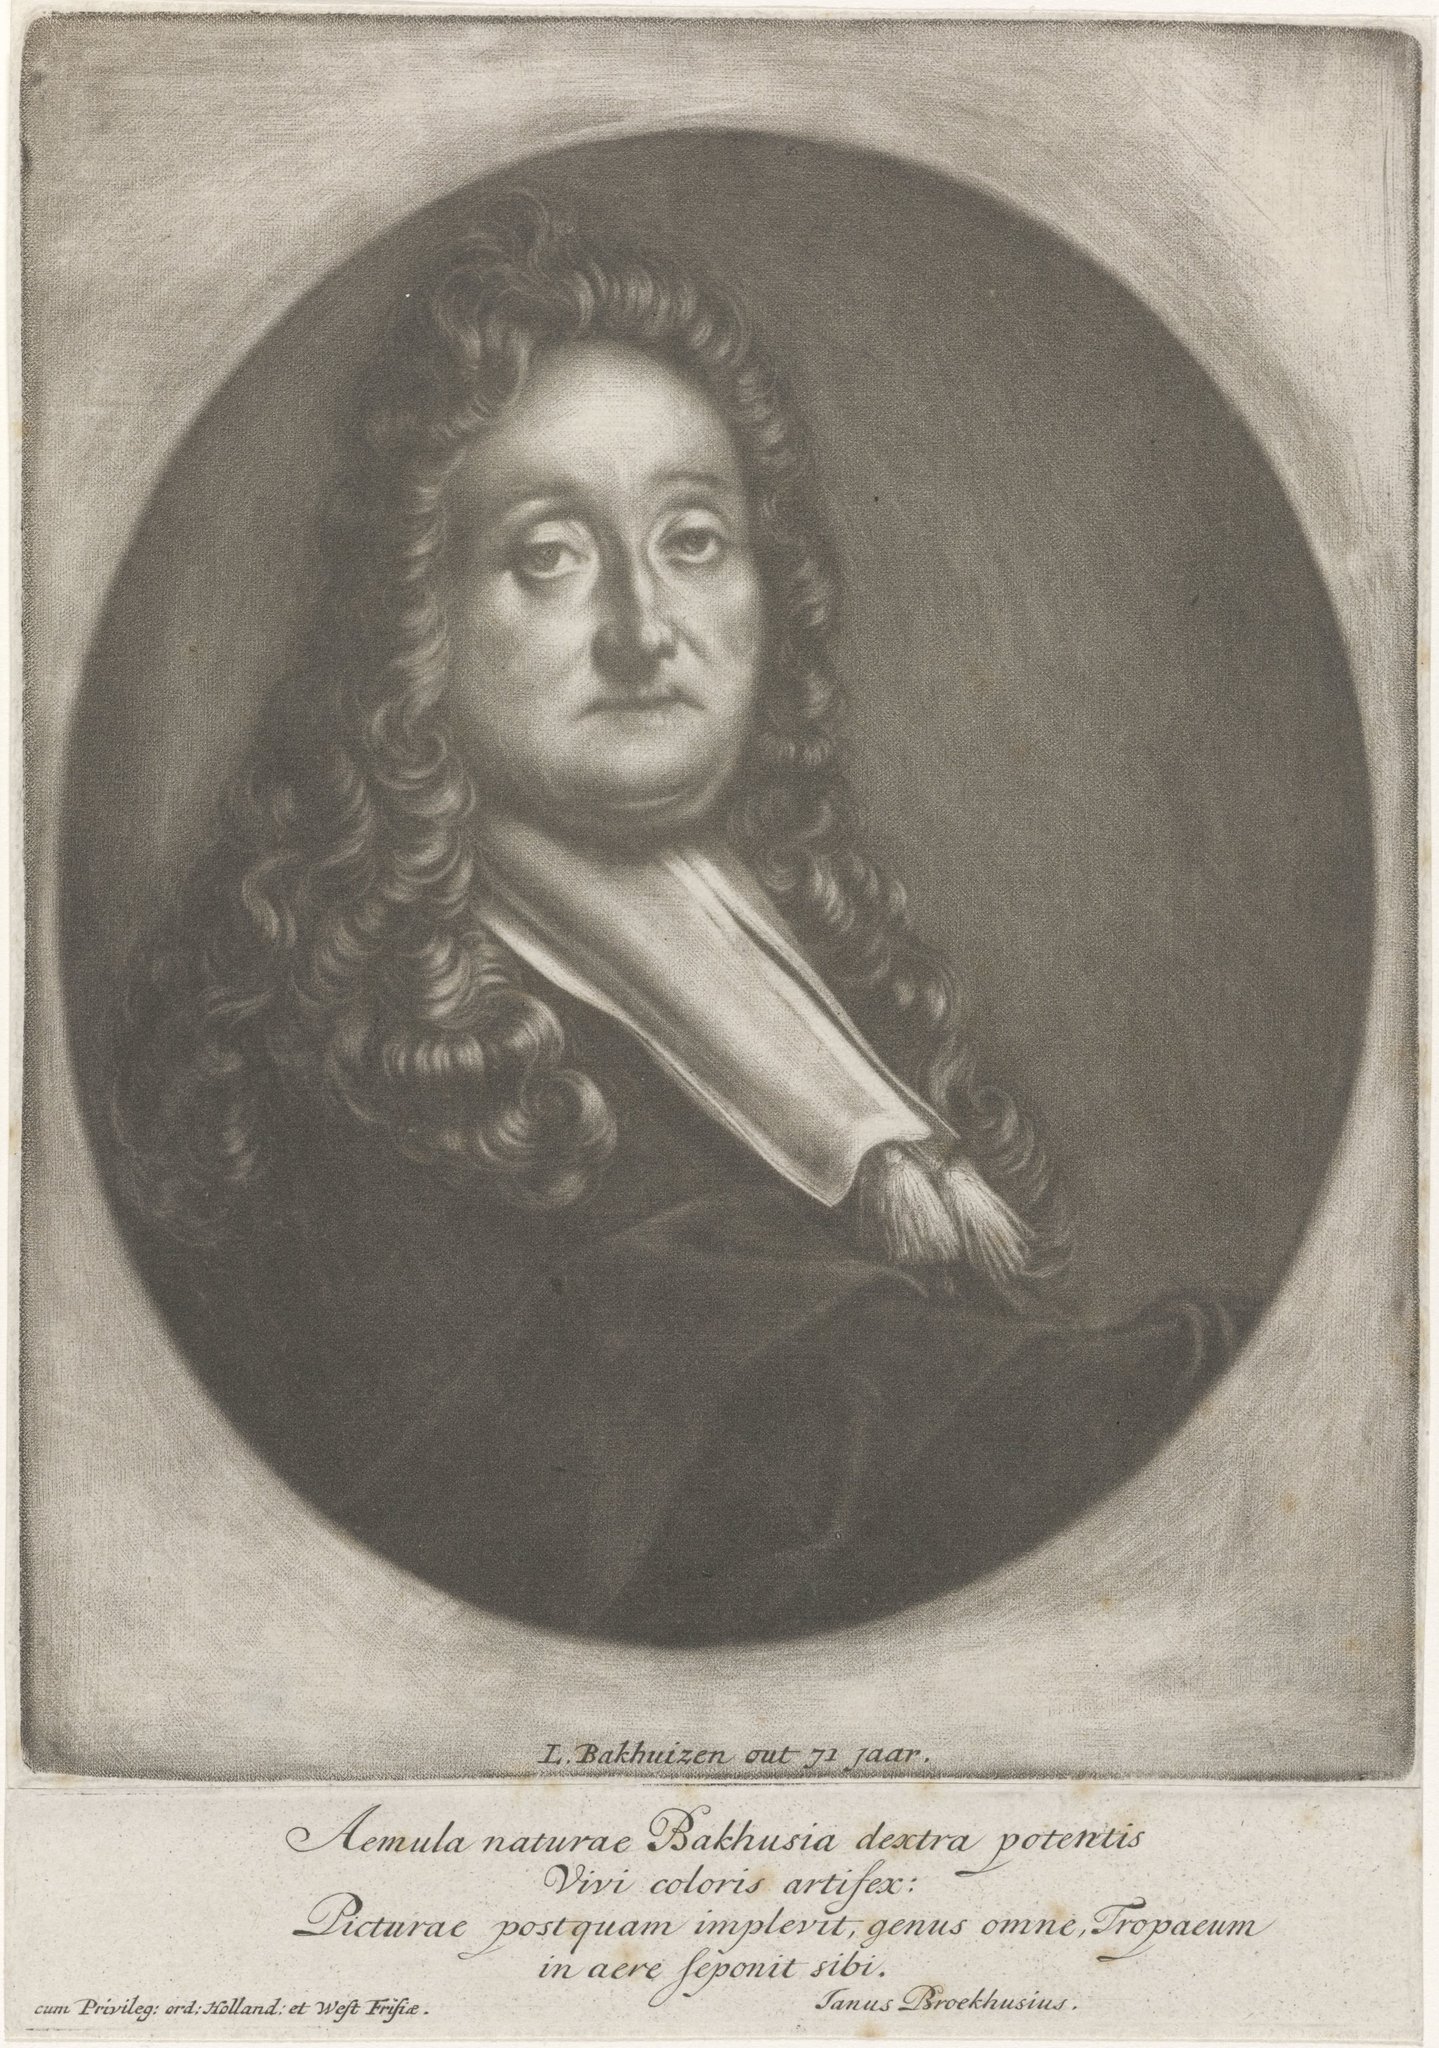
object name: print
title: Zelfportret van Ludolf Bakhuysen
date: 1670-1724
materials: paper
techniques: engraving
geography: amsterdam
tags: amsterdam, print maker, draughtsman, ludolf bakhuysen, portrait, self-portrait of painter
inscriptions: collector's mark: Lugt 2760, collector's mark: Lugt 2228, collector's mark: Lugt 2166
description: De zeeschilder Ludolf Bakhuysen op 71-jarige leeftijd. Onder het portret de naam en de leeftijd van de schilder. In de marge een vierregelig vers in het Latijn.